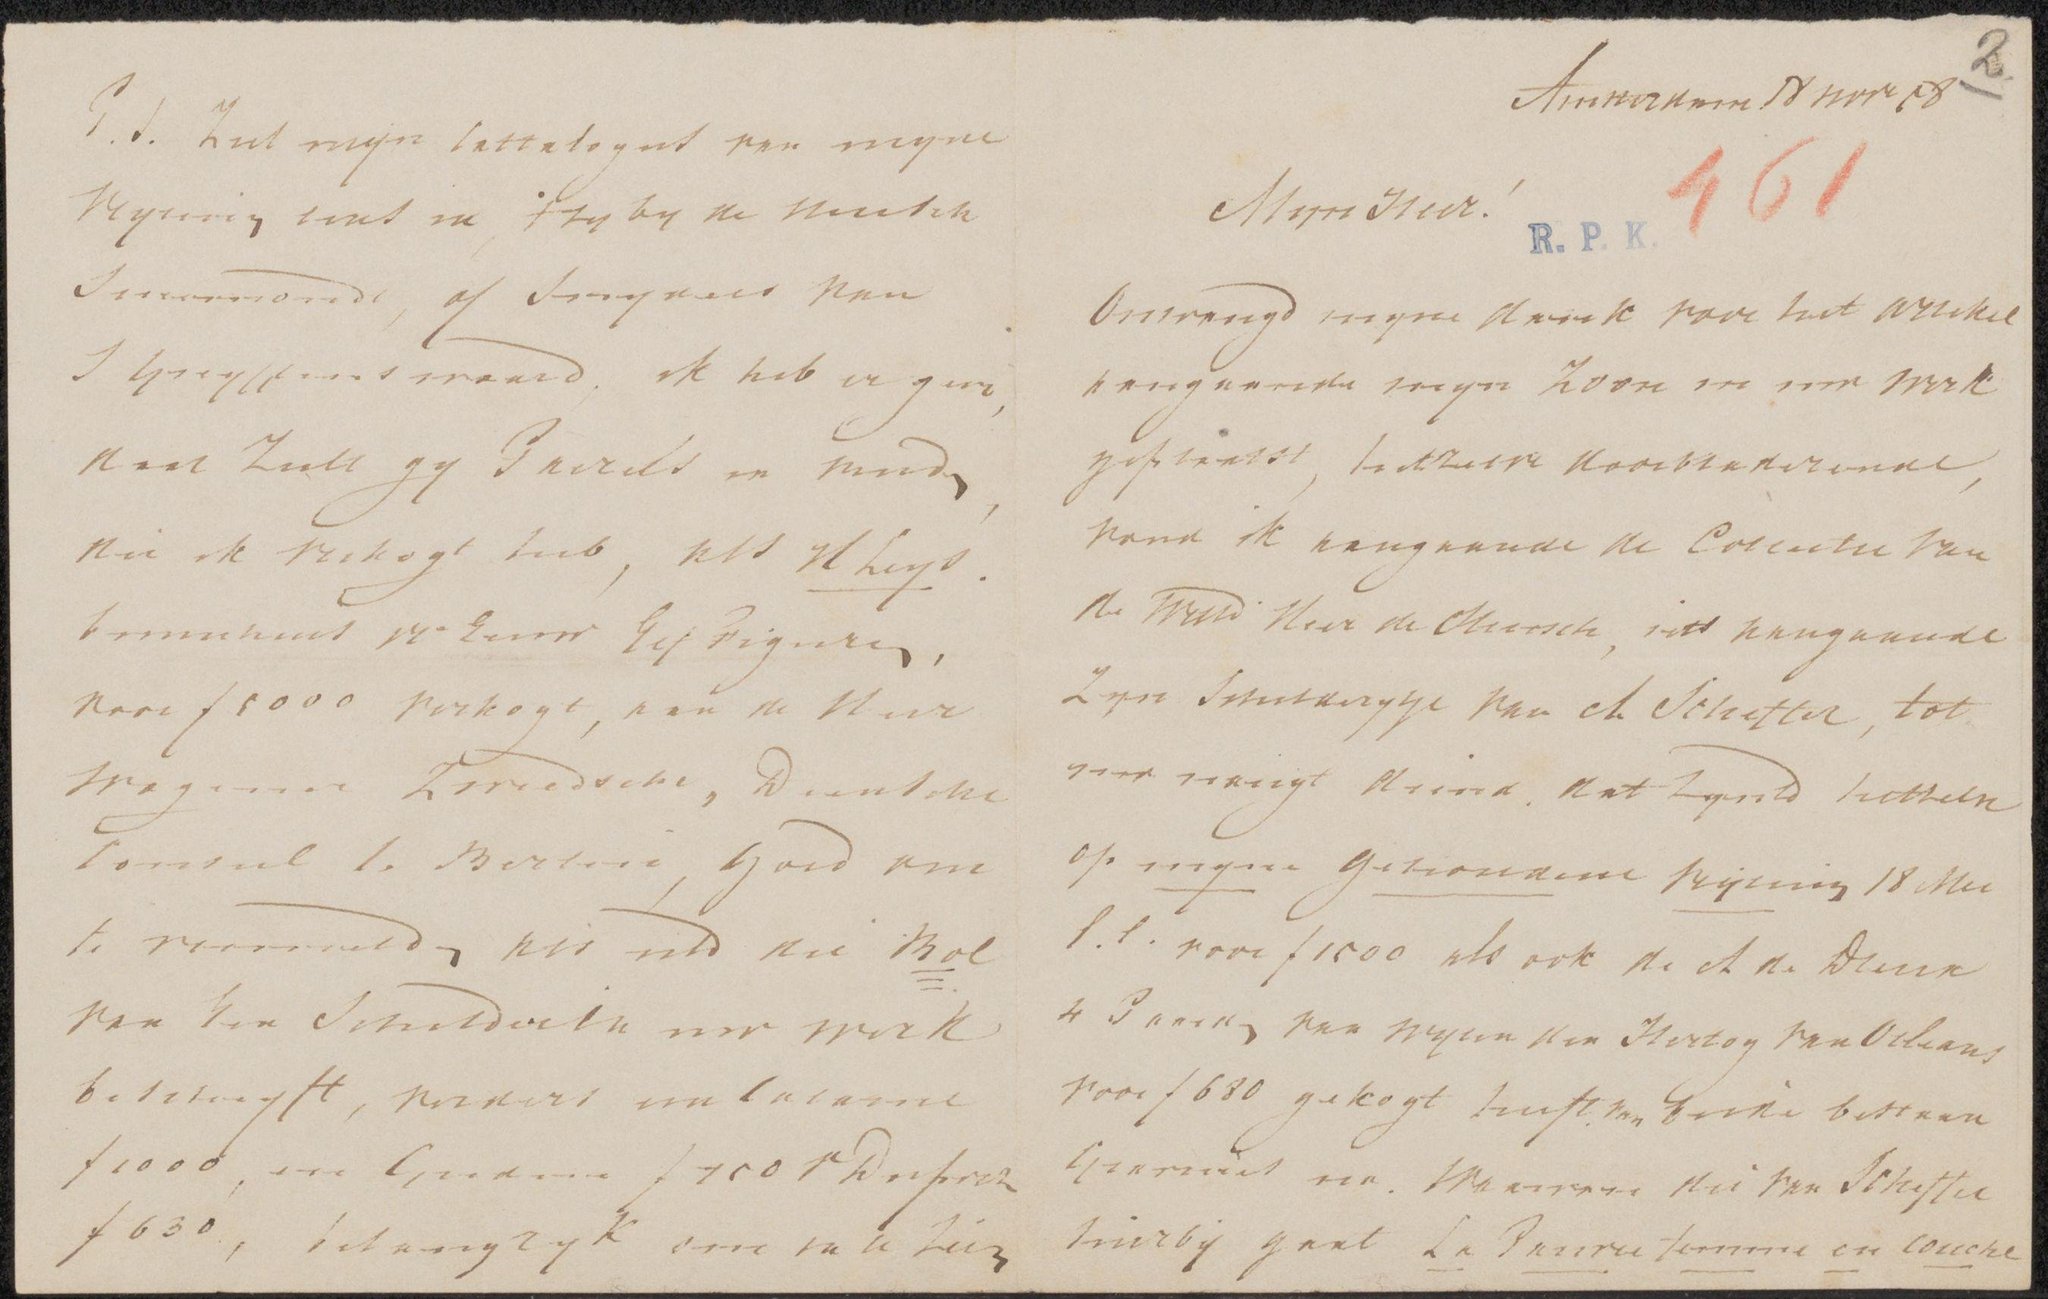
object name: letter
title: Brief aan Christiaan Kramm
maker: h. hilleveld hzn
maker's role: kunsthandelaar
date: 1858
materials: ink, paper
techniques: pen, writing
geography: amsterdam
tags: amsterdam, adrianus david hilleveld, dordrecht, painter, print maker, draughtsman, sculptor, ary scheffer, cornelis kruseman, utrecht, christiaan kramm, art trade, art shop, the graphic arts, painting (including book-illumination, miniature-painting), money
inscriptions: collector's mark: Lugt 2233